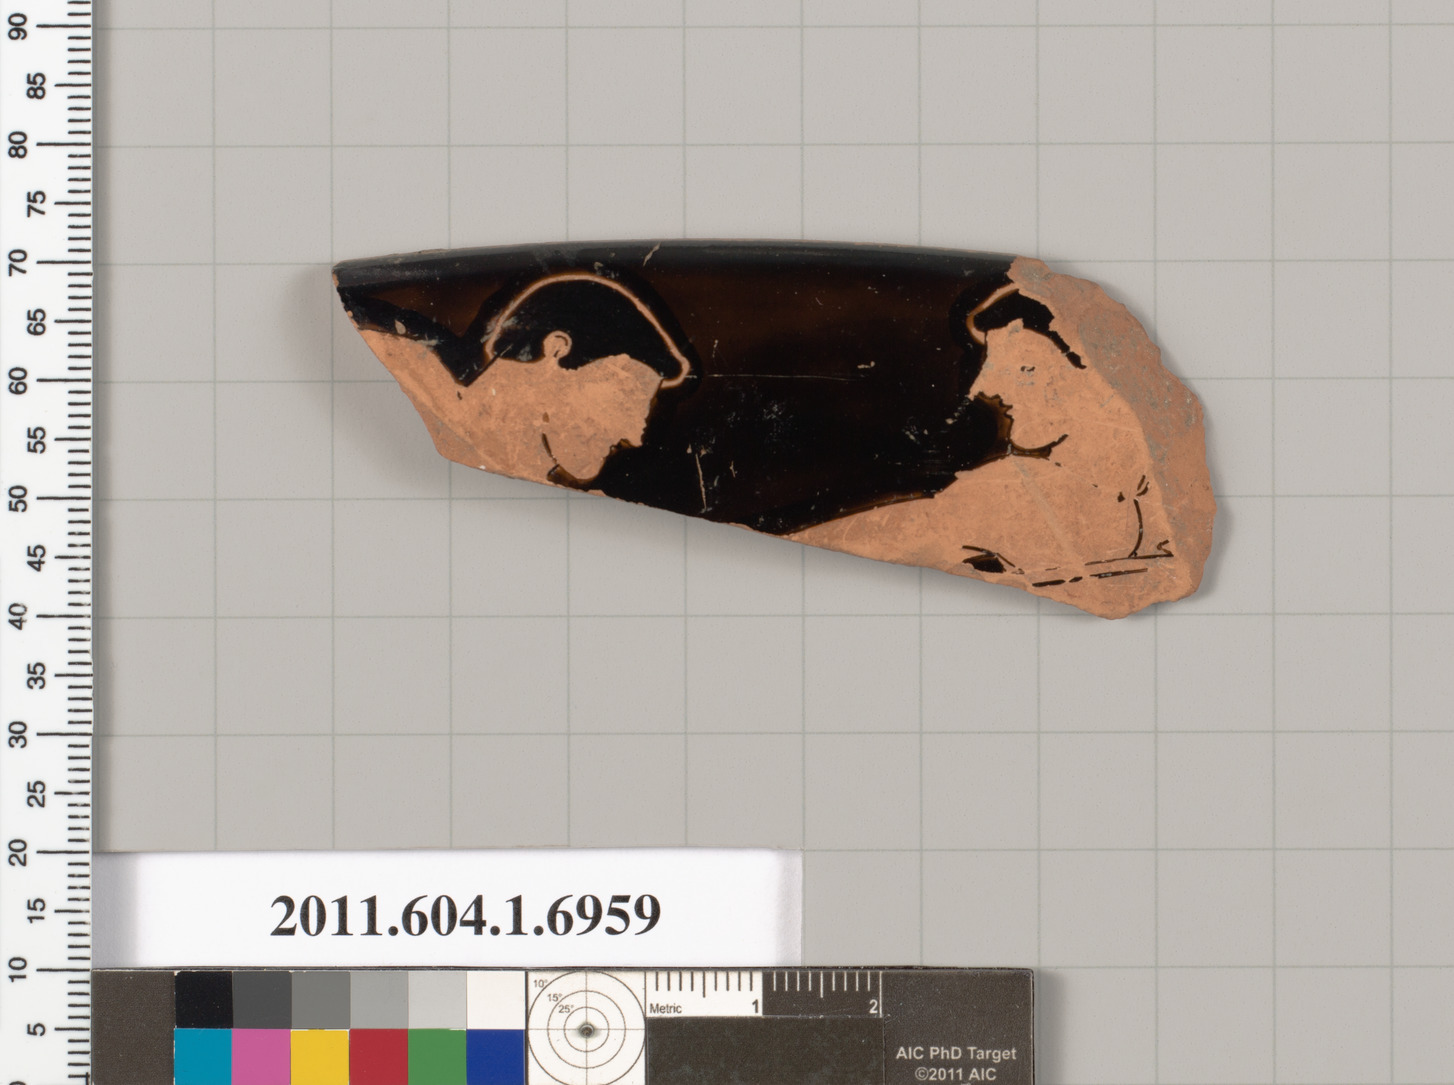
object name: kylix fragment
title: Terracotta rim fragment of a kylix (drinking cup)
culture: greek, attic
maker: painter of the paris gigantomachy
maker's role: artist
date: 480-470 BCE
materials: terracotta